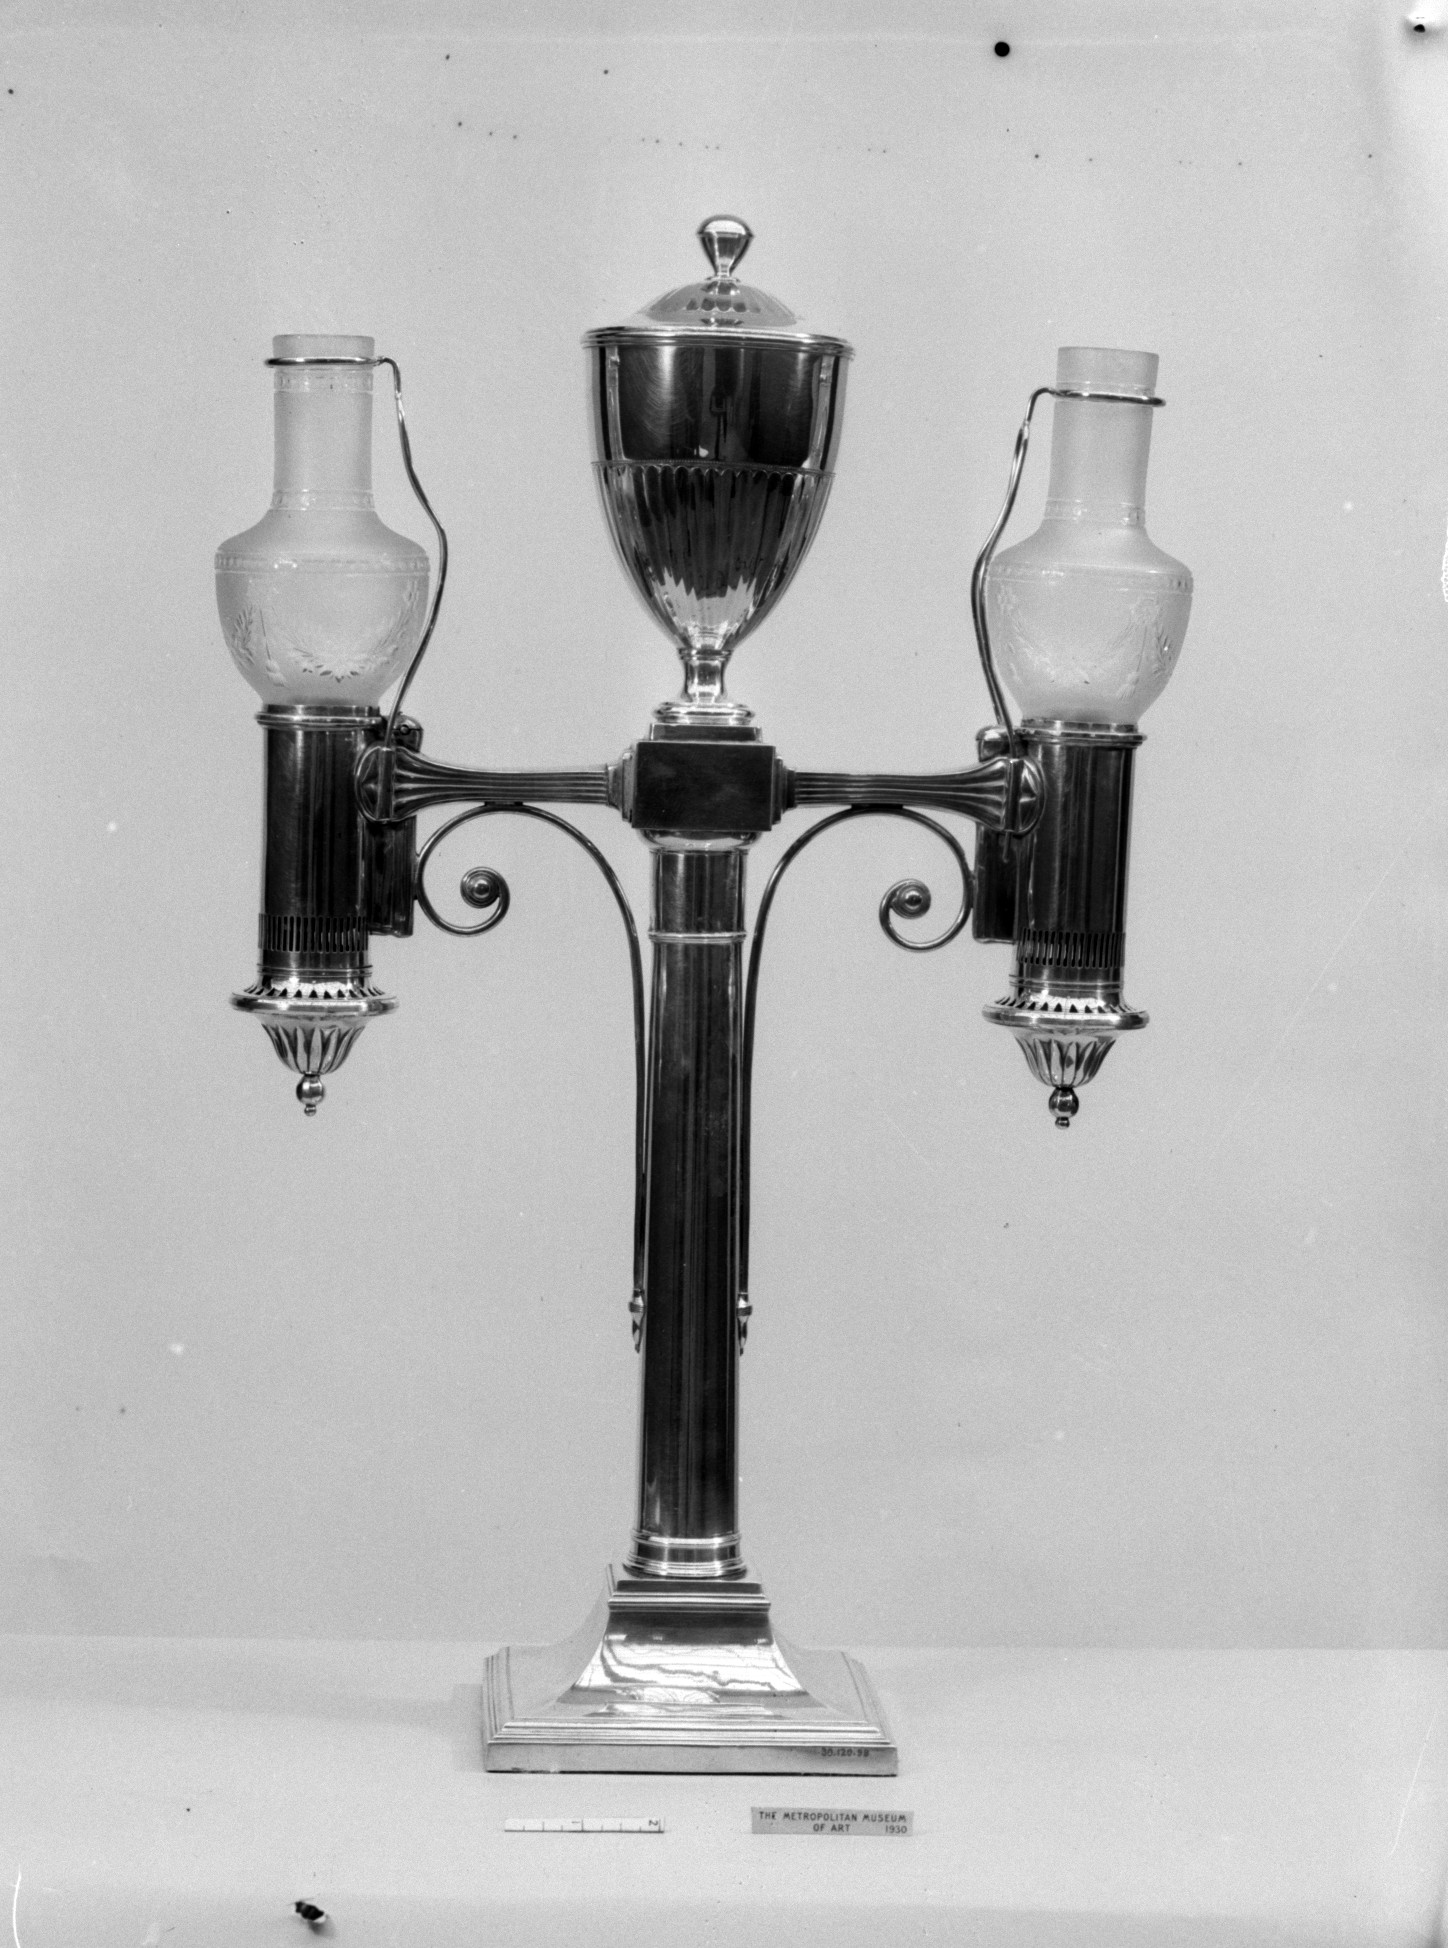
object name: lamp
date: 1790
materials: glass, metal